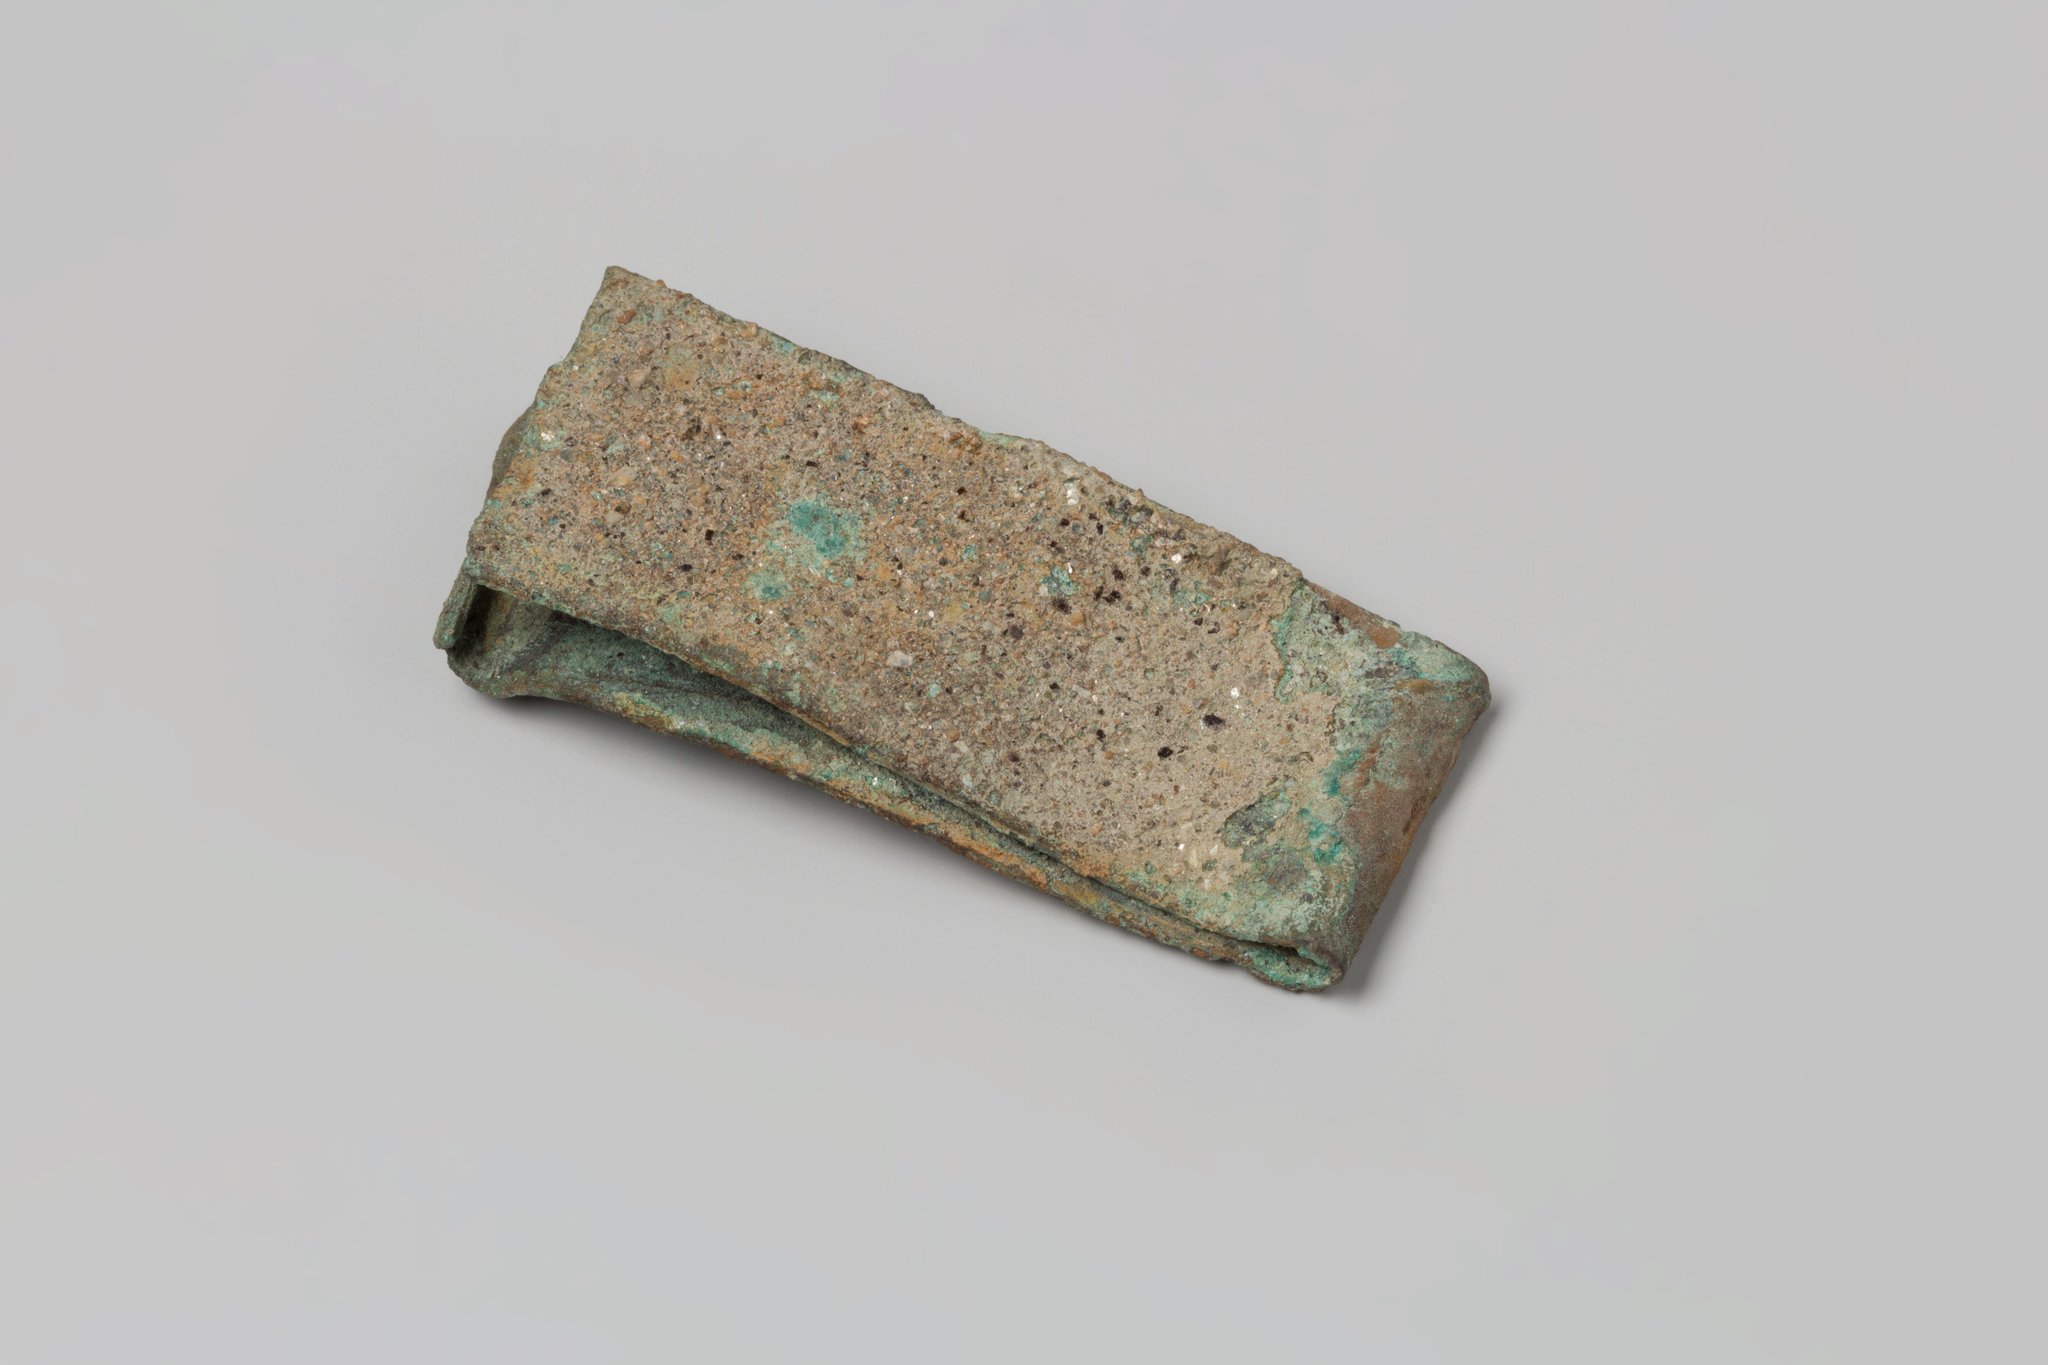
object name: firehose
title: Fragment van brandslangring uit het wrak van de Oost-Indiëvaarder Hollandia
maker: Anonymous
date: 1700-1743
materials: copper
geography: netherlands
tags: verenigde oostindische compagnie, hollandia (schip), annet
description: Fire engine, firehose; fragments, id. NG-1975-20-H-1271-a, squashed corroded.